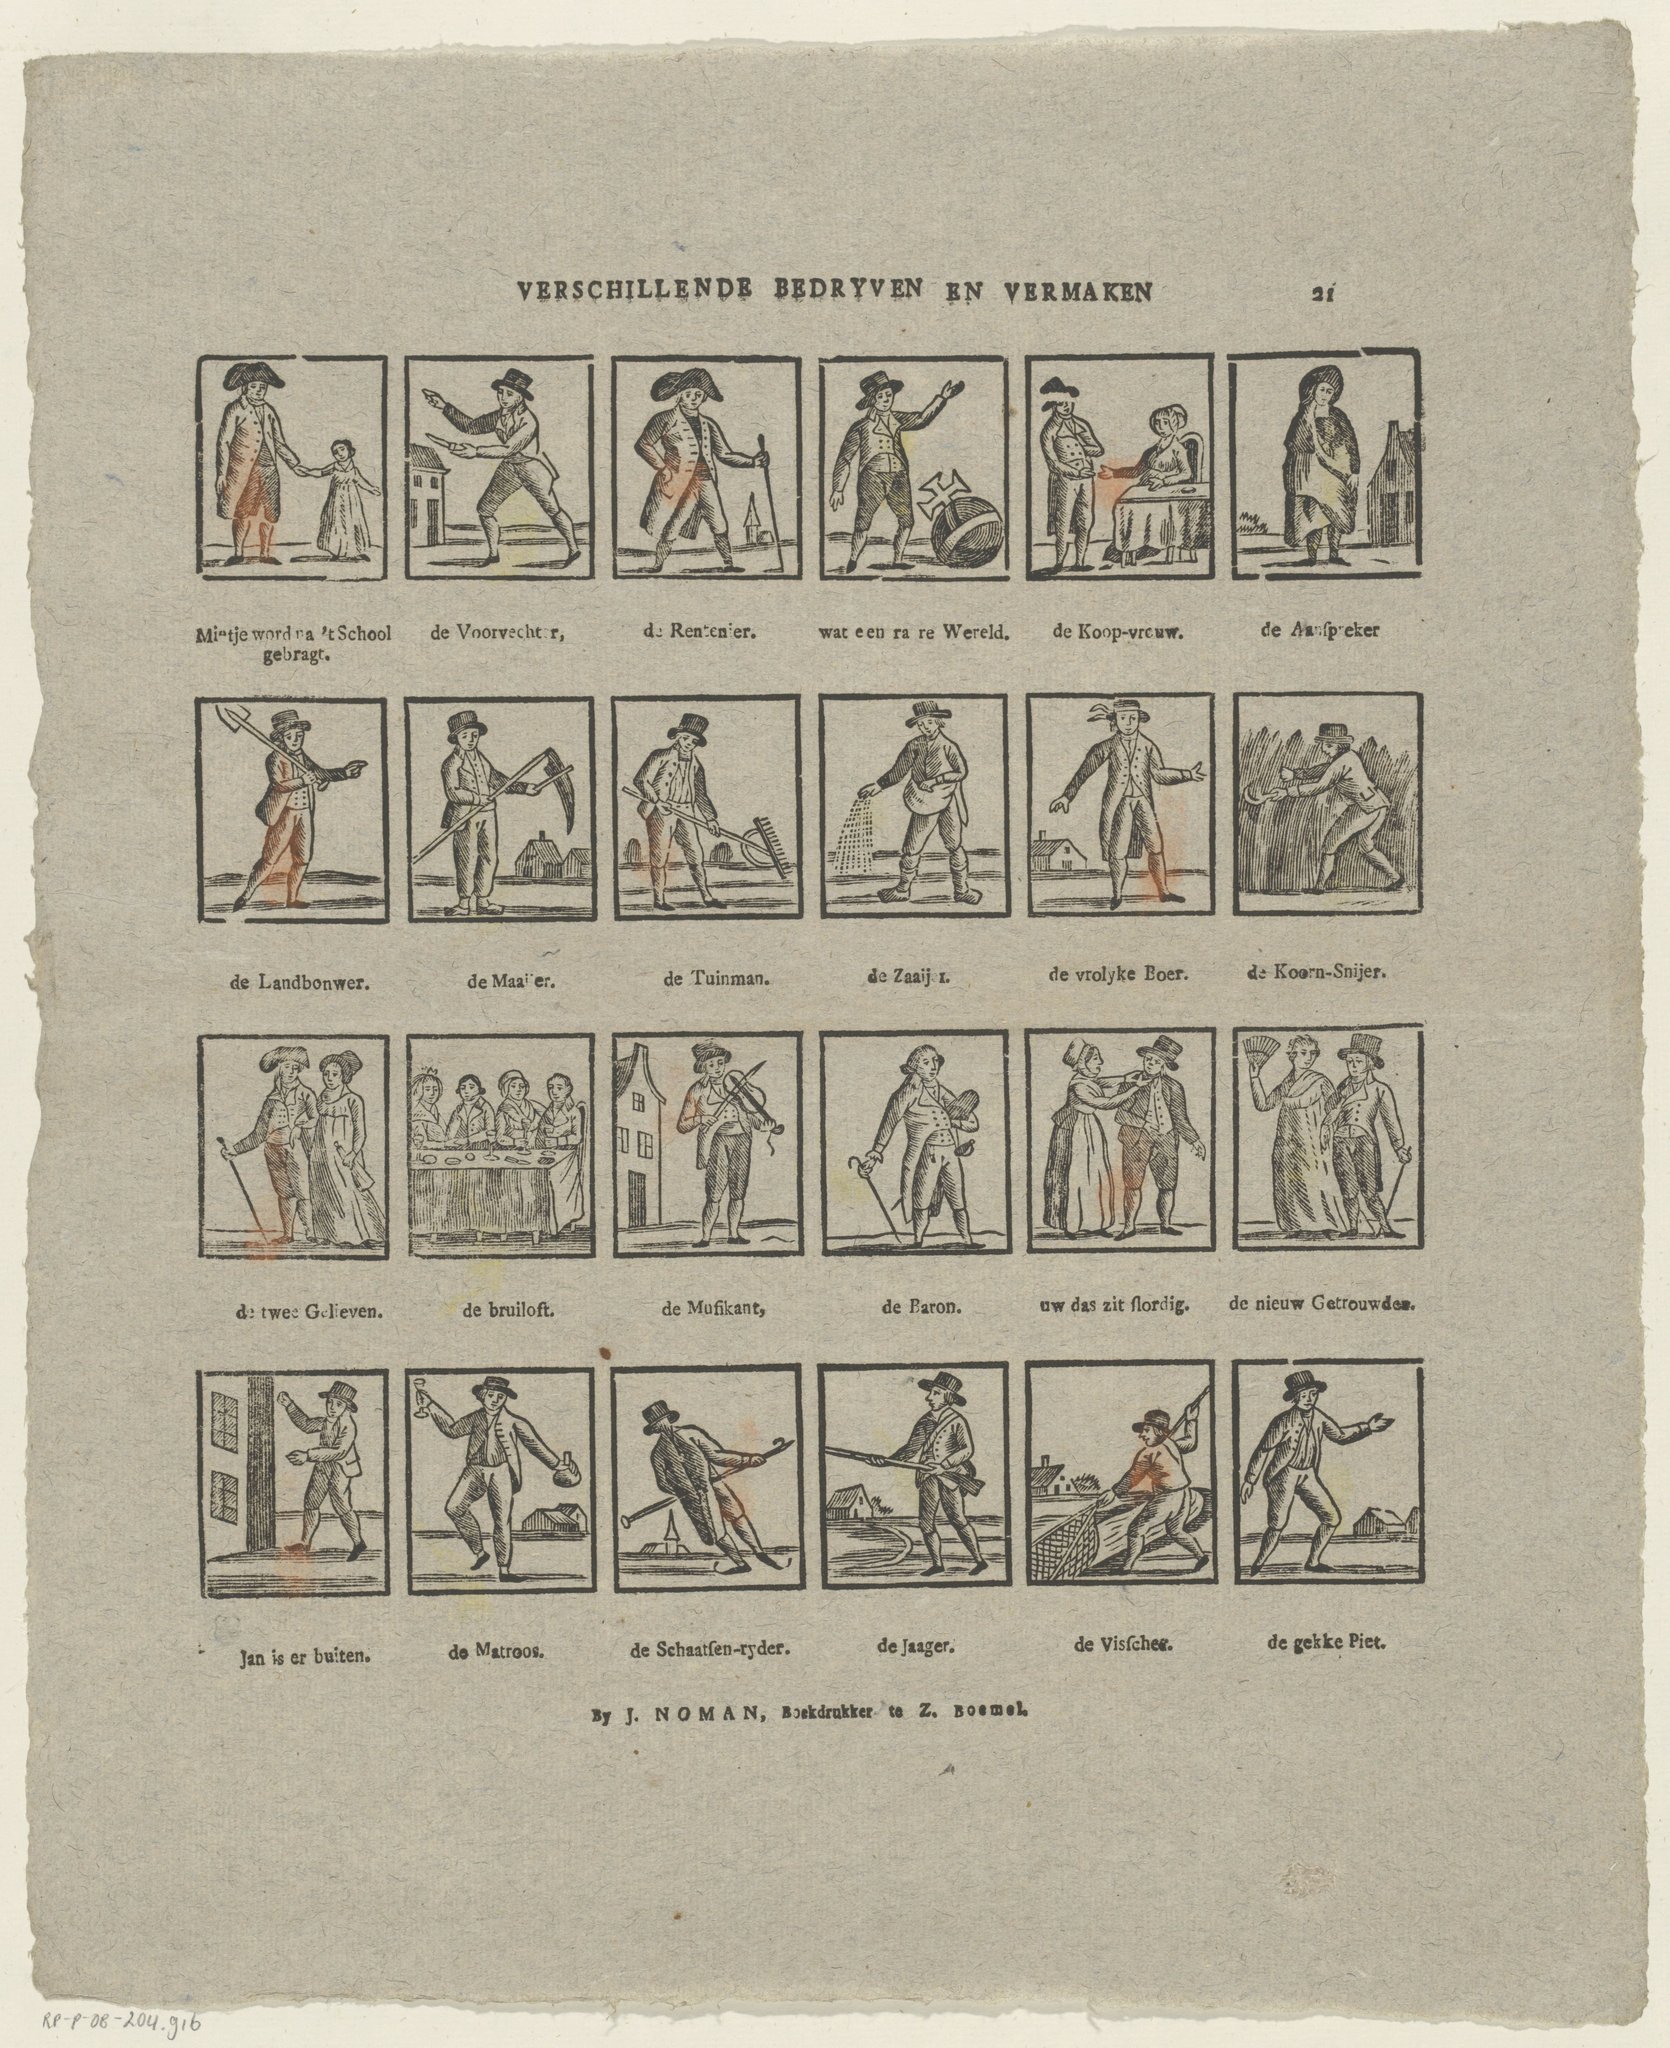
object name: print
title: Verschillende bedryven en vermaken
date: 1806-1830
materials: paper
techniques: colour, letterpress printing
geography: zaltbommel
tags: musician at work, human types, farmers, skates (winter sports), fisherman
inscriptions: collector's mark: Lugt 2760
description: Blad met 24 voorstellingen van verschillende figuren, beroepen en bezigheden. Onder elke voorstelling een onderschrift. Genummerd rechtsboven: 21.